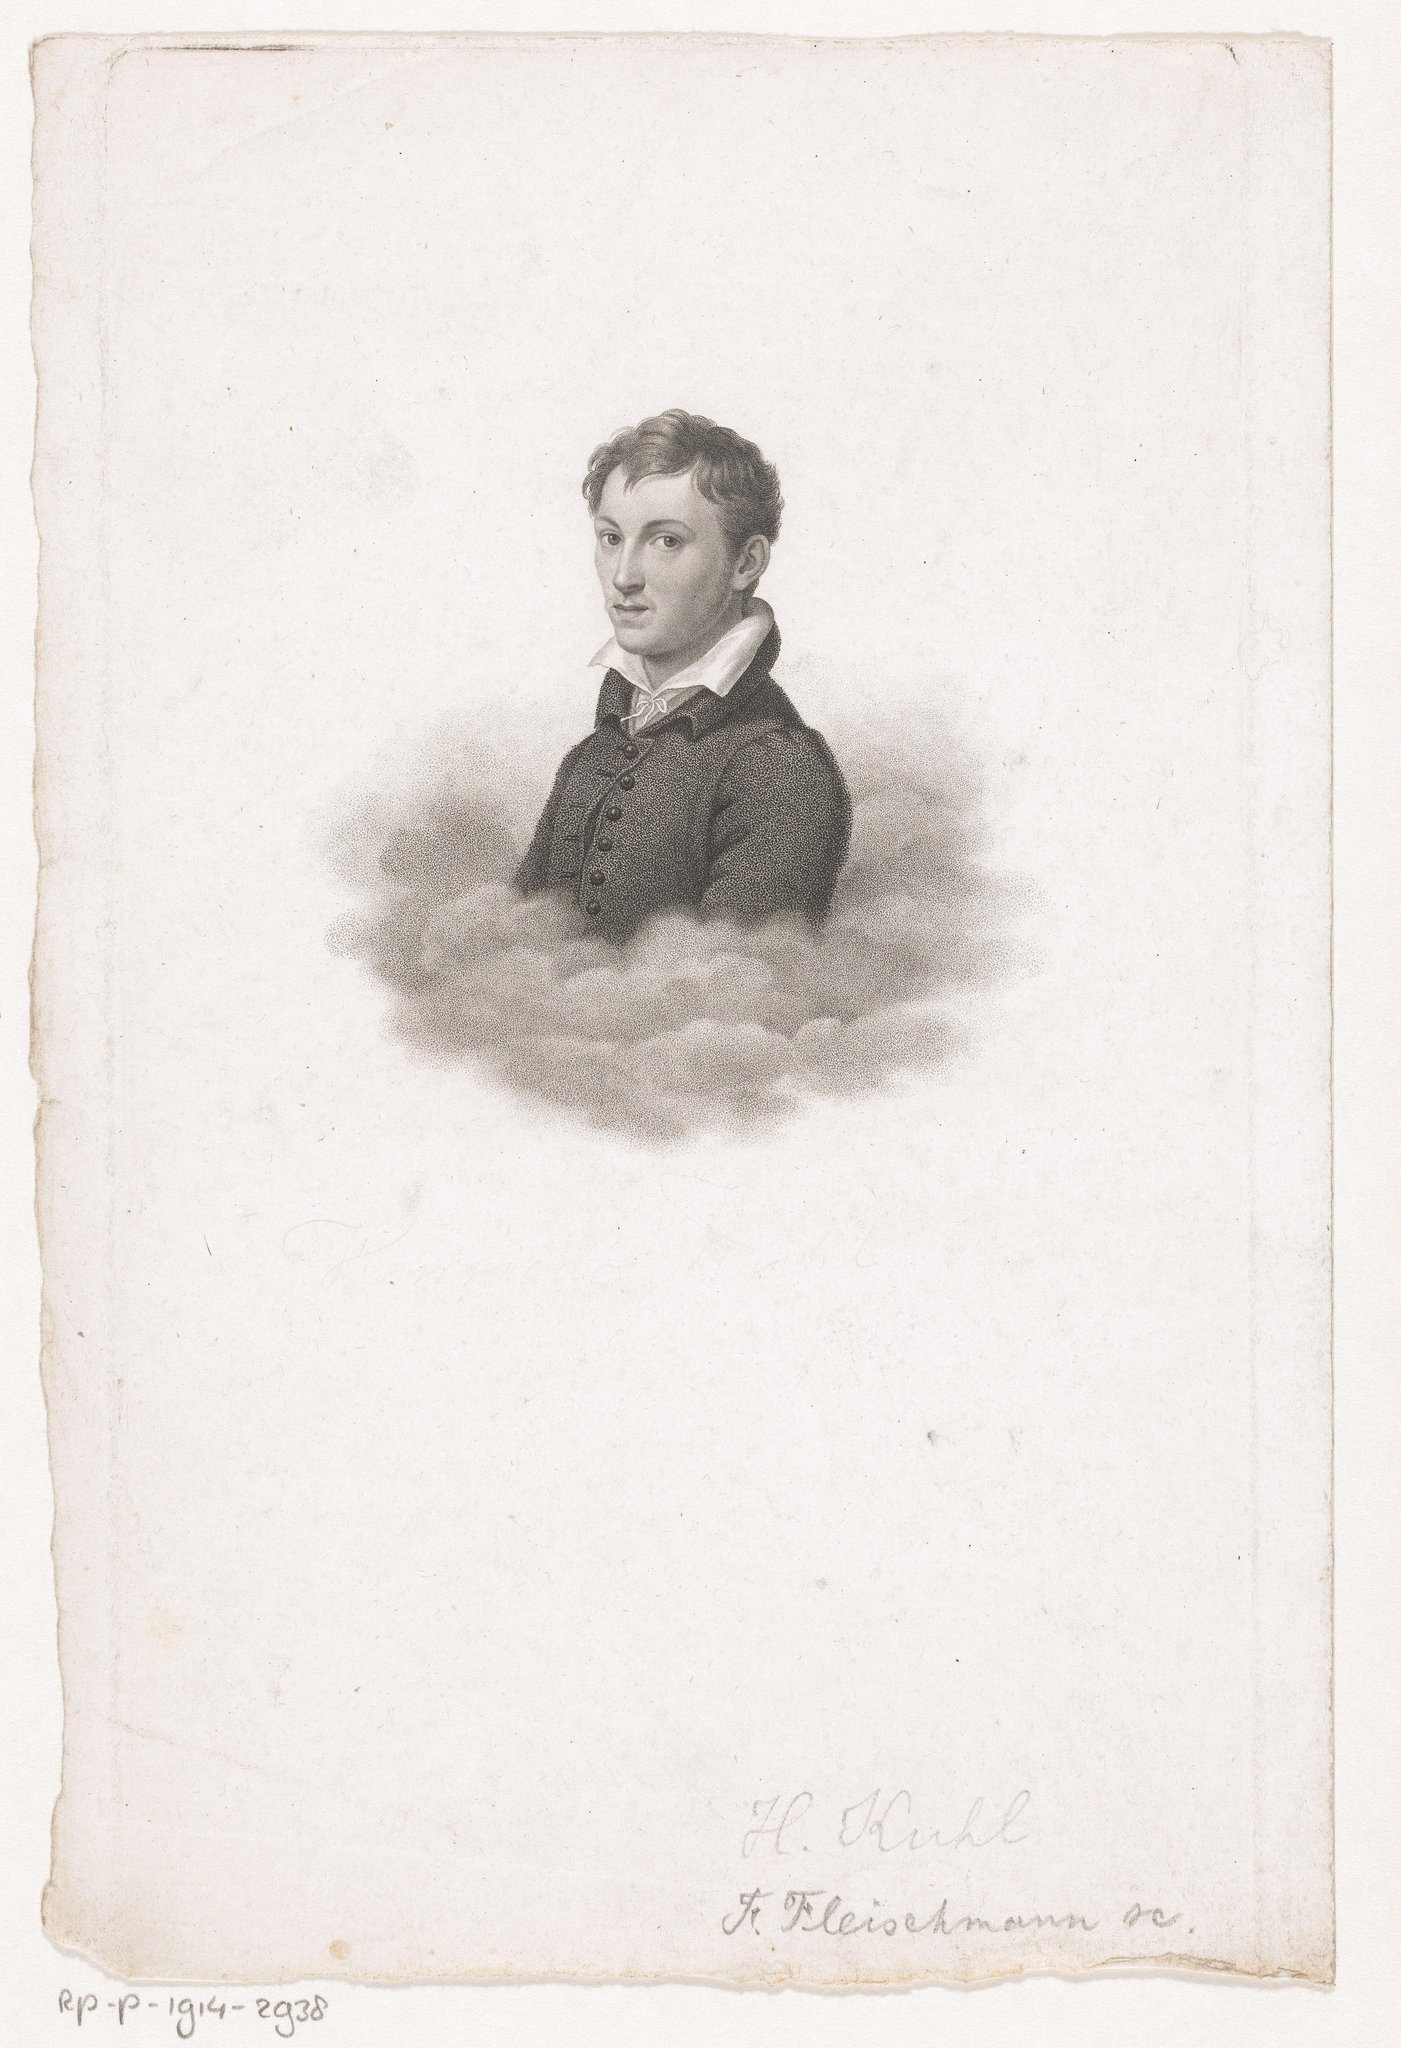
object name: print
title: Portret van Henricus Kuhl op 24-jarige leeftijd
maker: friedrich fleischmann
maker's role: print maker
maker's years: 1791-1834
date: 1821-1834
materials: paper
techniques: stippling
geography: nuremberg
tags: clouds, historical persons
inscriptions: collector's mark: Lugt 2228